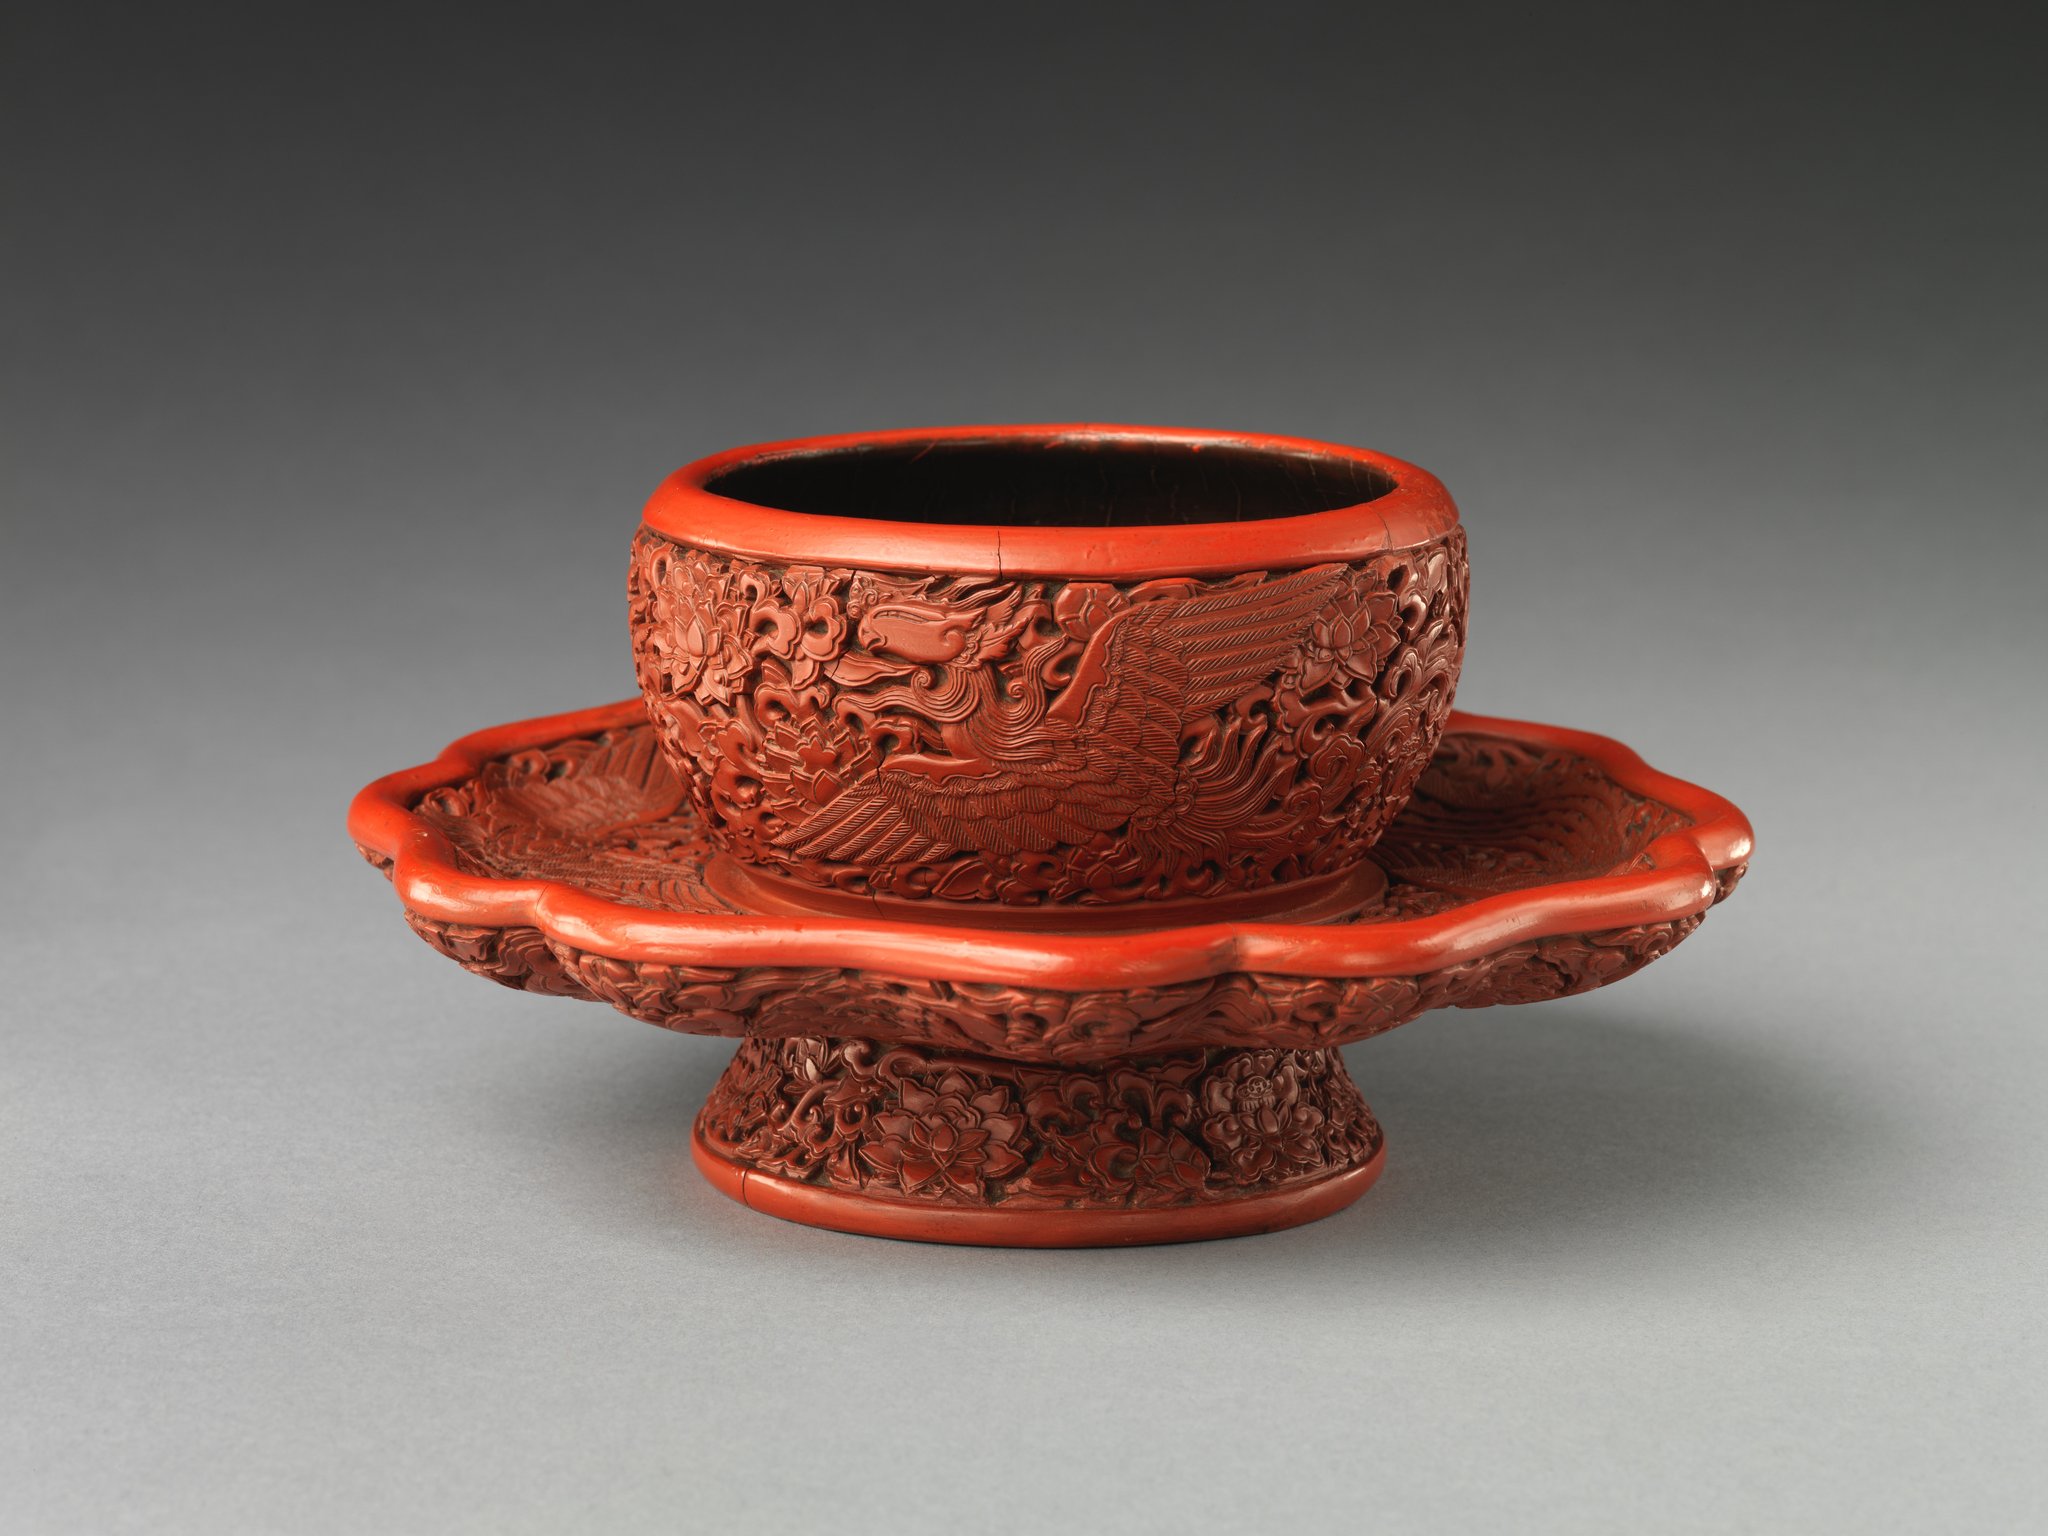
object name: stand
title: Tea-bowl stand with phoenixes amid flowers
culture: chinese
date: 1403-1424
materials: lacquer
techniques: carving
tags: phoenix